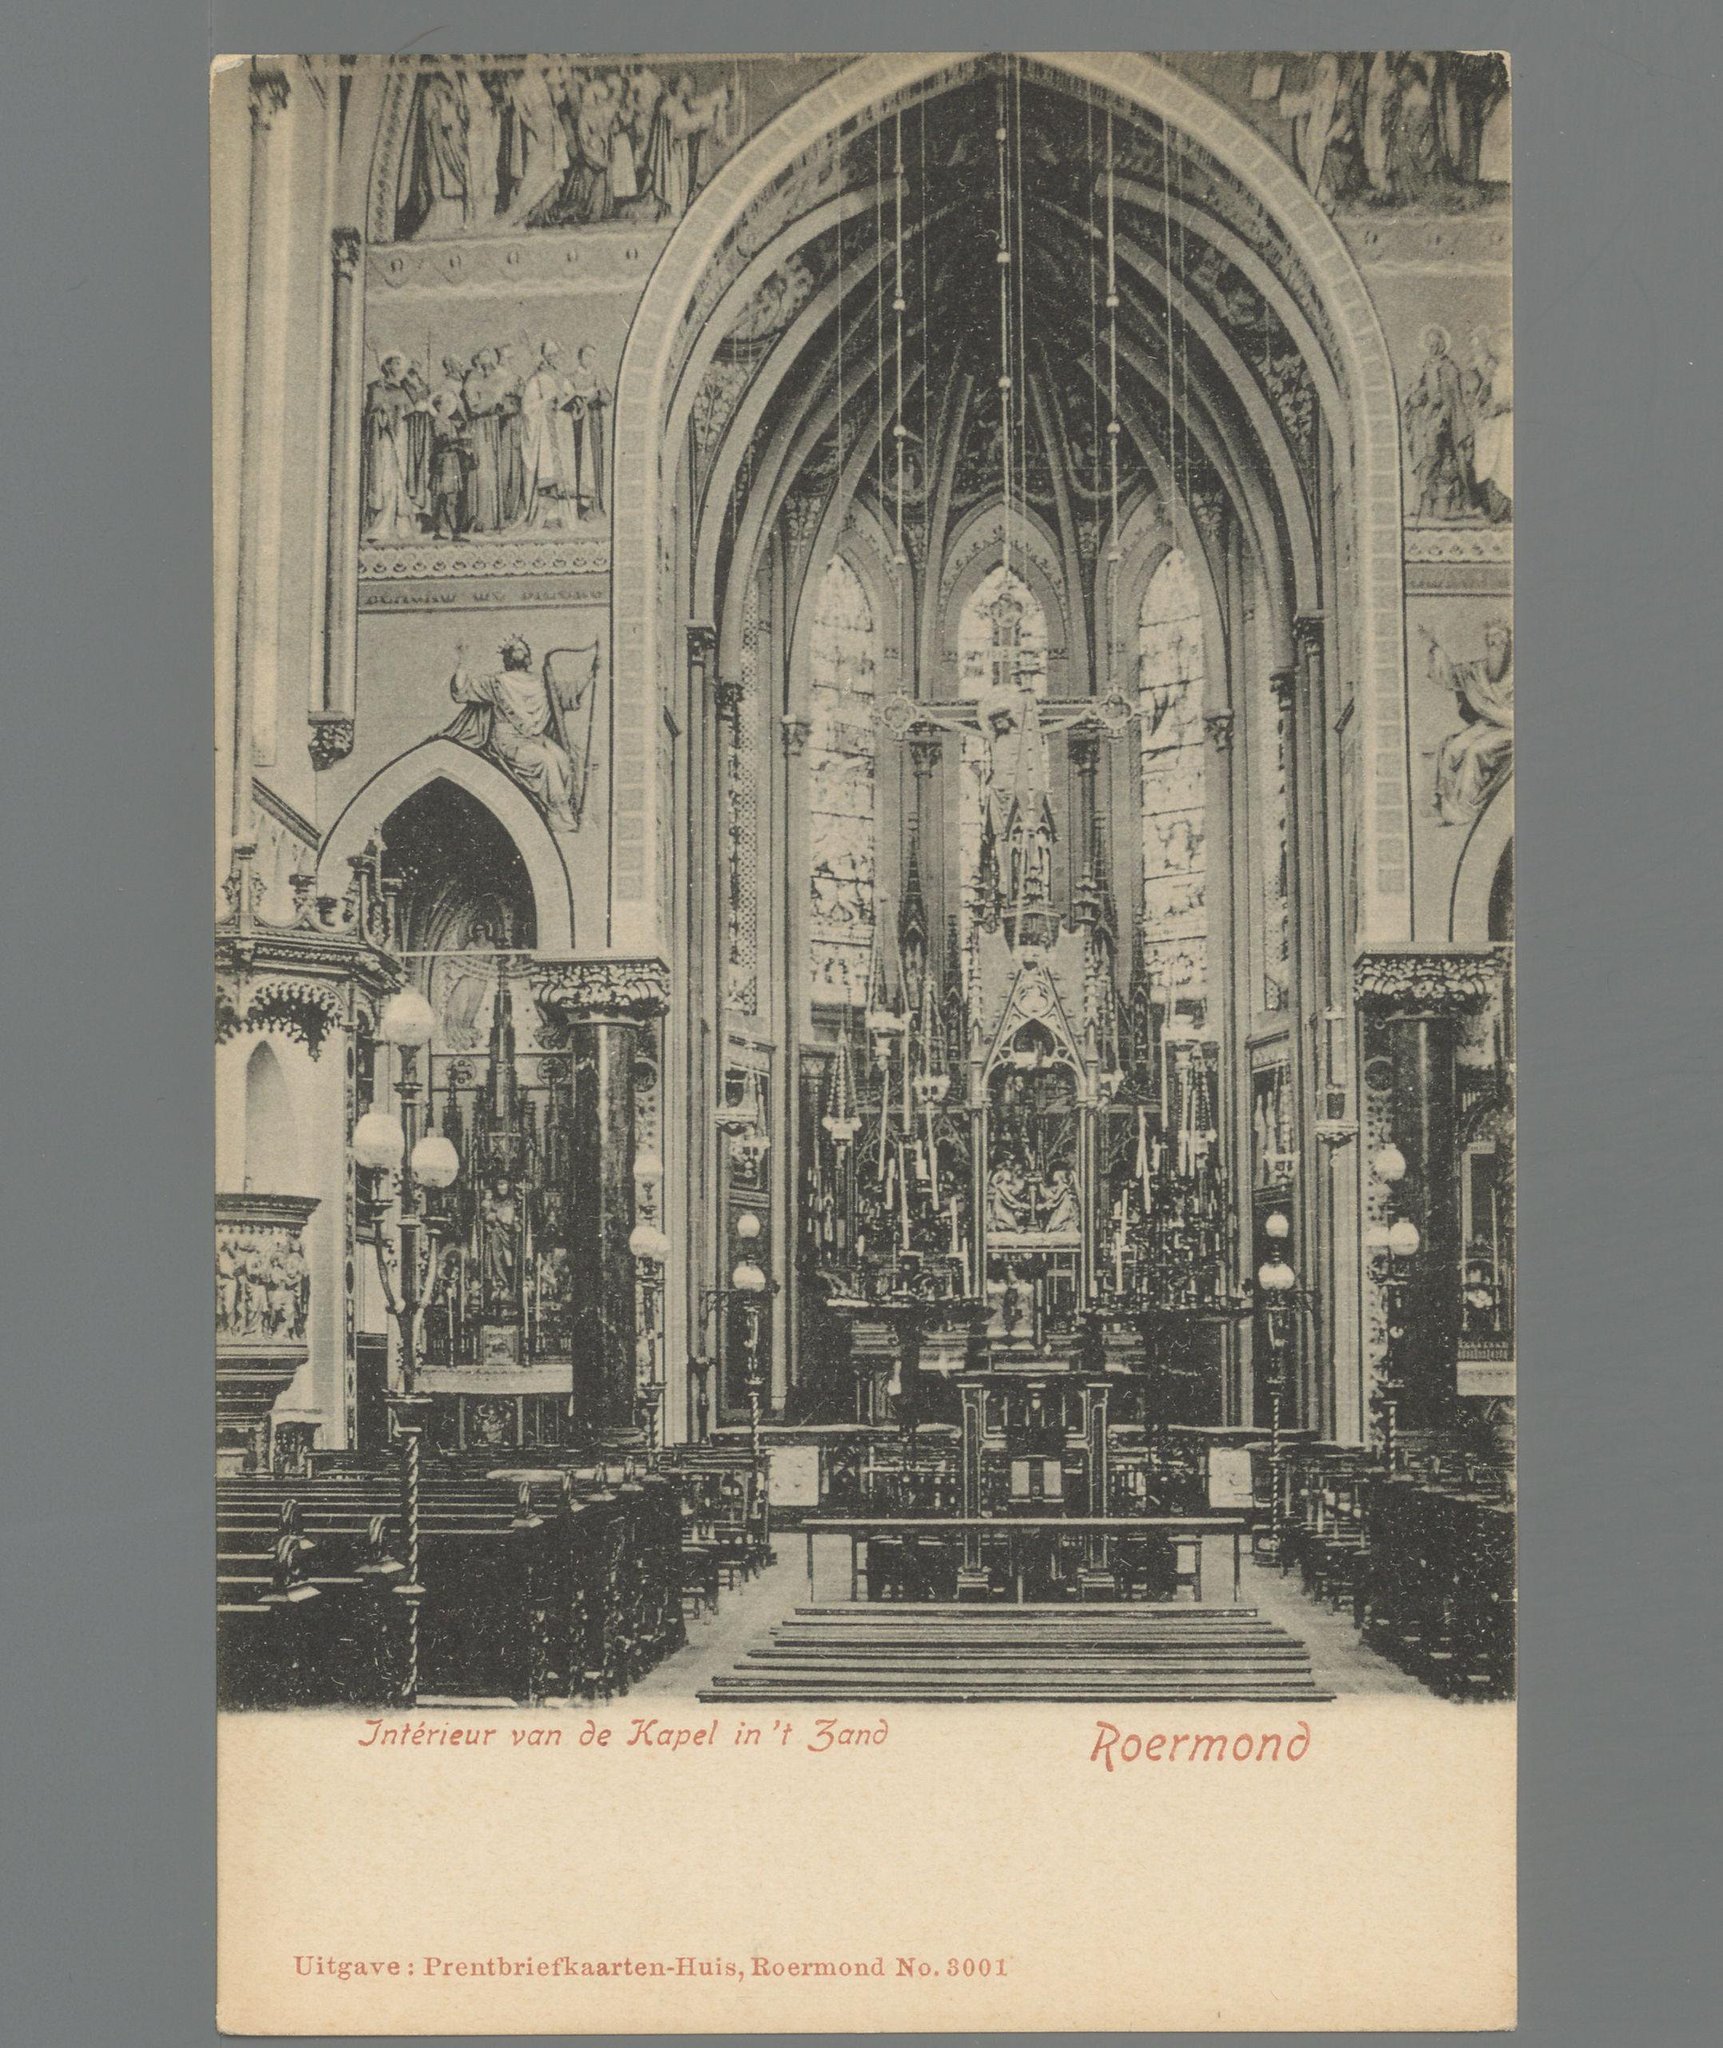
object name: photomechanical print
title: Intérieur van de Kapel in 't Zand. Roermond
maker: Anonymous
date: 1897-1905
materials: cardboard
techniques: photograph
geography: roermond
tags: parts of church interior: nave, interior of church